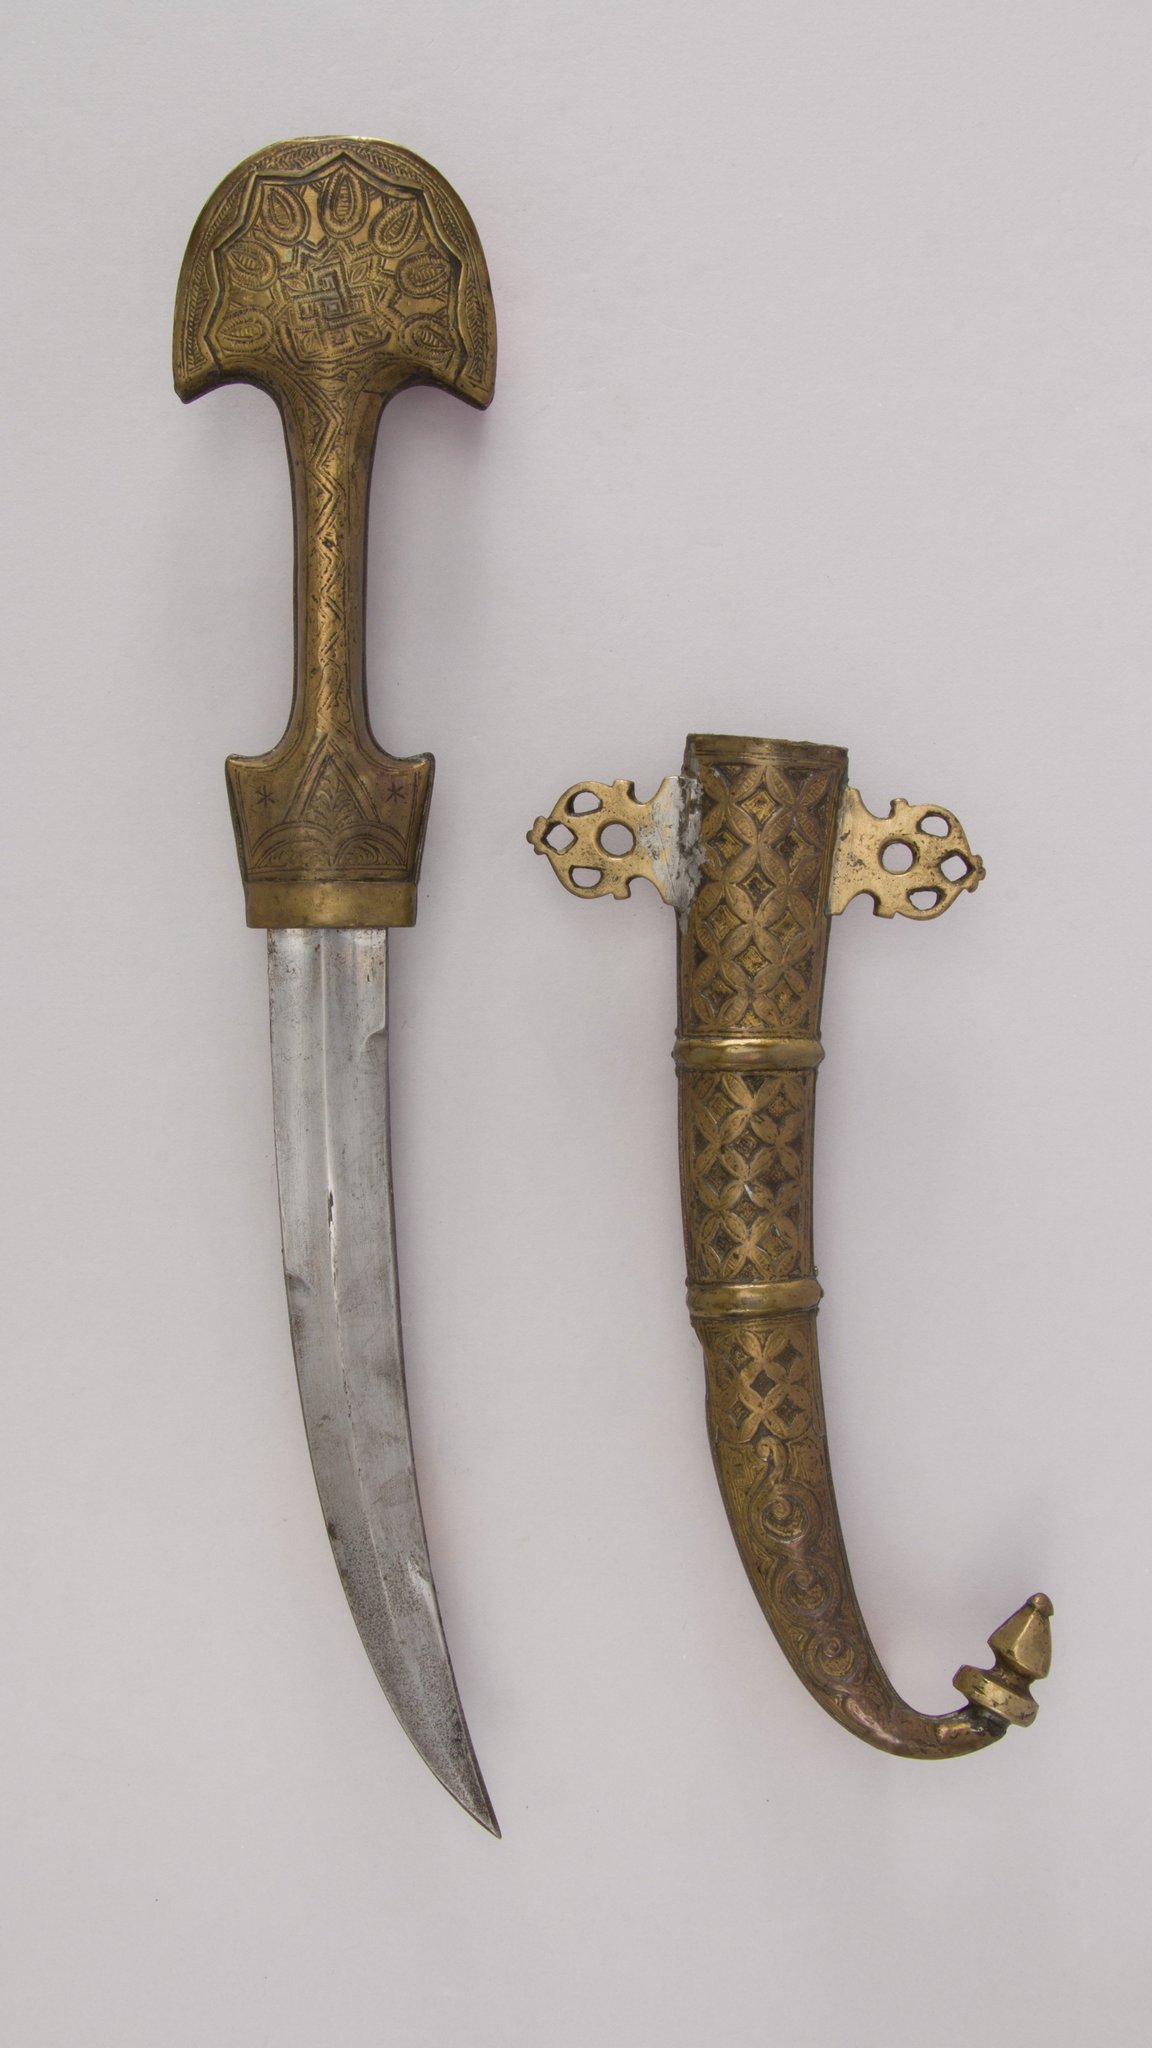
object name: dagger jambiya with sheath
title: Dagger (Jambiya) with Sheath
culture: moroccan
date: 1701-1900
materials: brass, silver, steel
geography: morocco